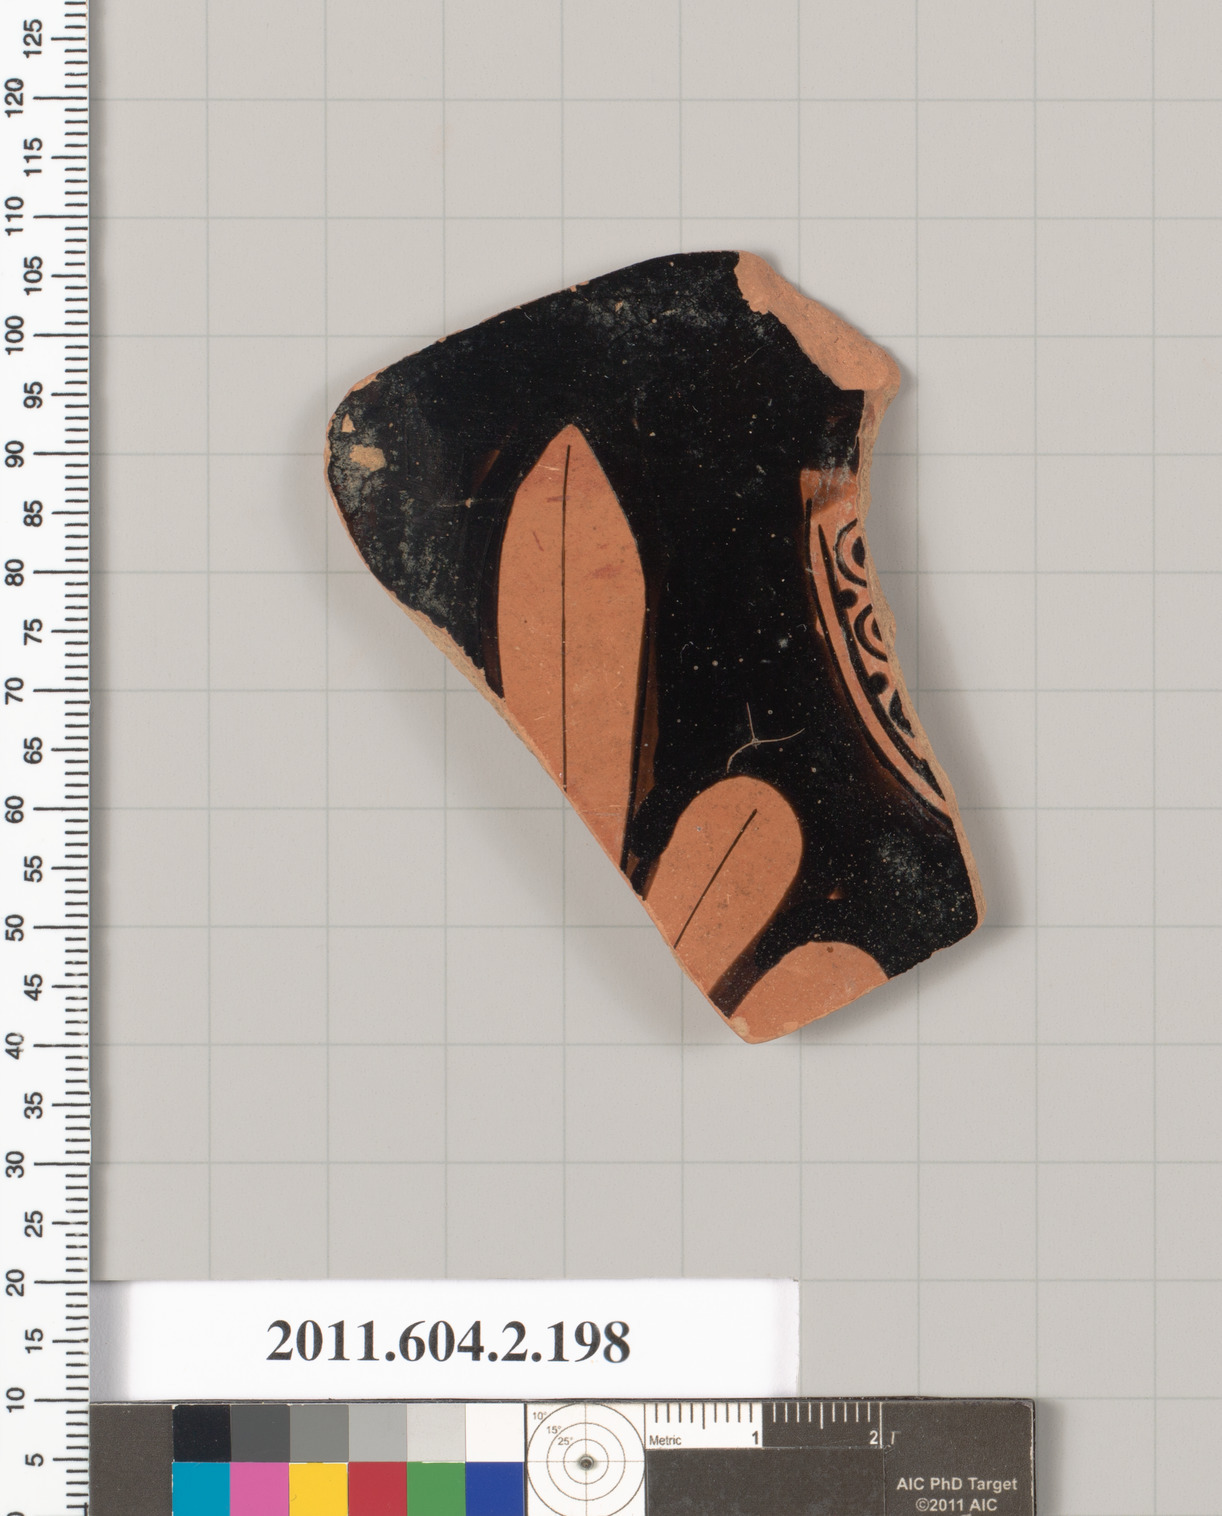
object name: stamnos fragment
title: Terracotta fragment of a stamnos (jar)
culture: greek, attic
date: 520-500 BCE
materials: terracotta